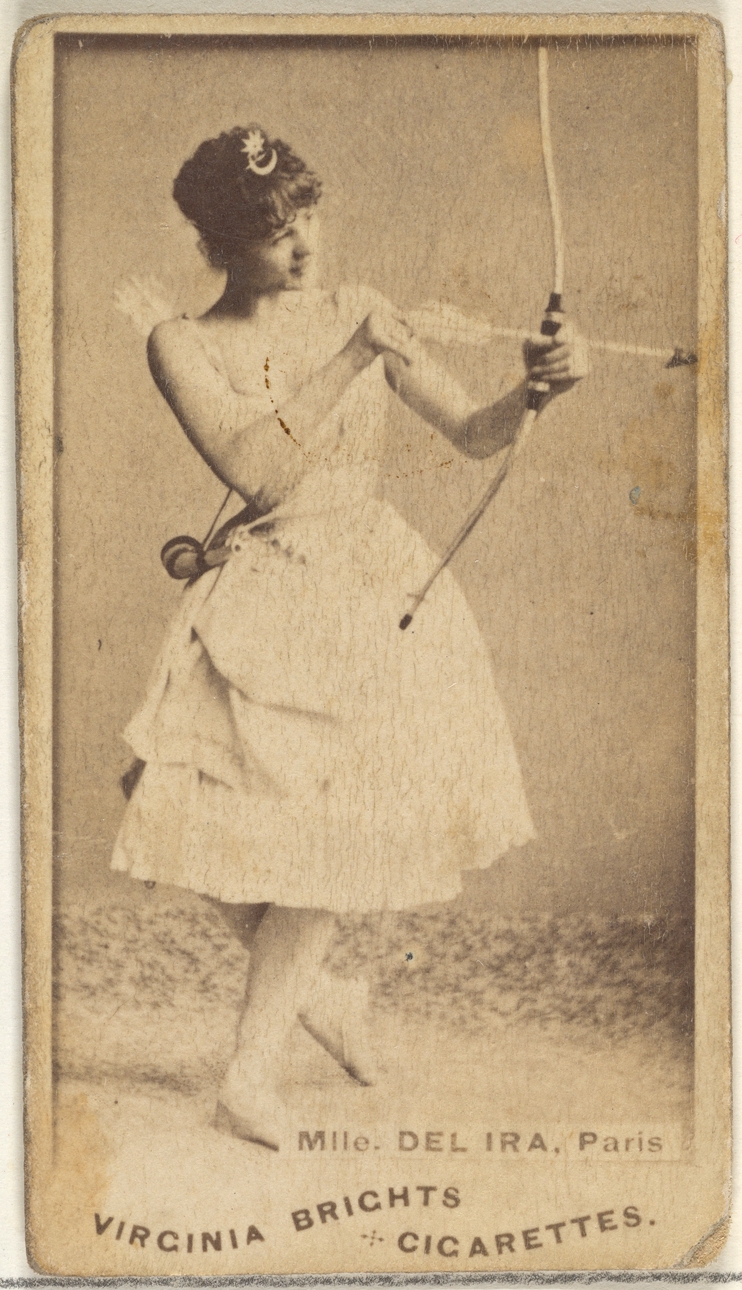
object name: photograph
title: Mlle. Del Ira, Paris, from the Actors and Actresses series (N45, Type 1) for Virginia Brights Cigarettes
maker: allen & ginter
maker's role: publisher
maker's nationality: american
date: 1888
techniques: albumen silver print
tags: bow and arrow,portraits,women,actresses